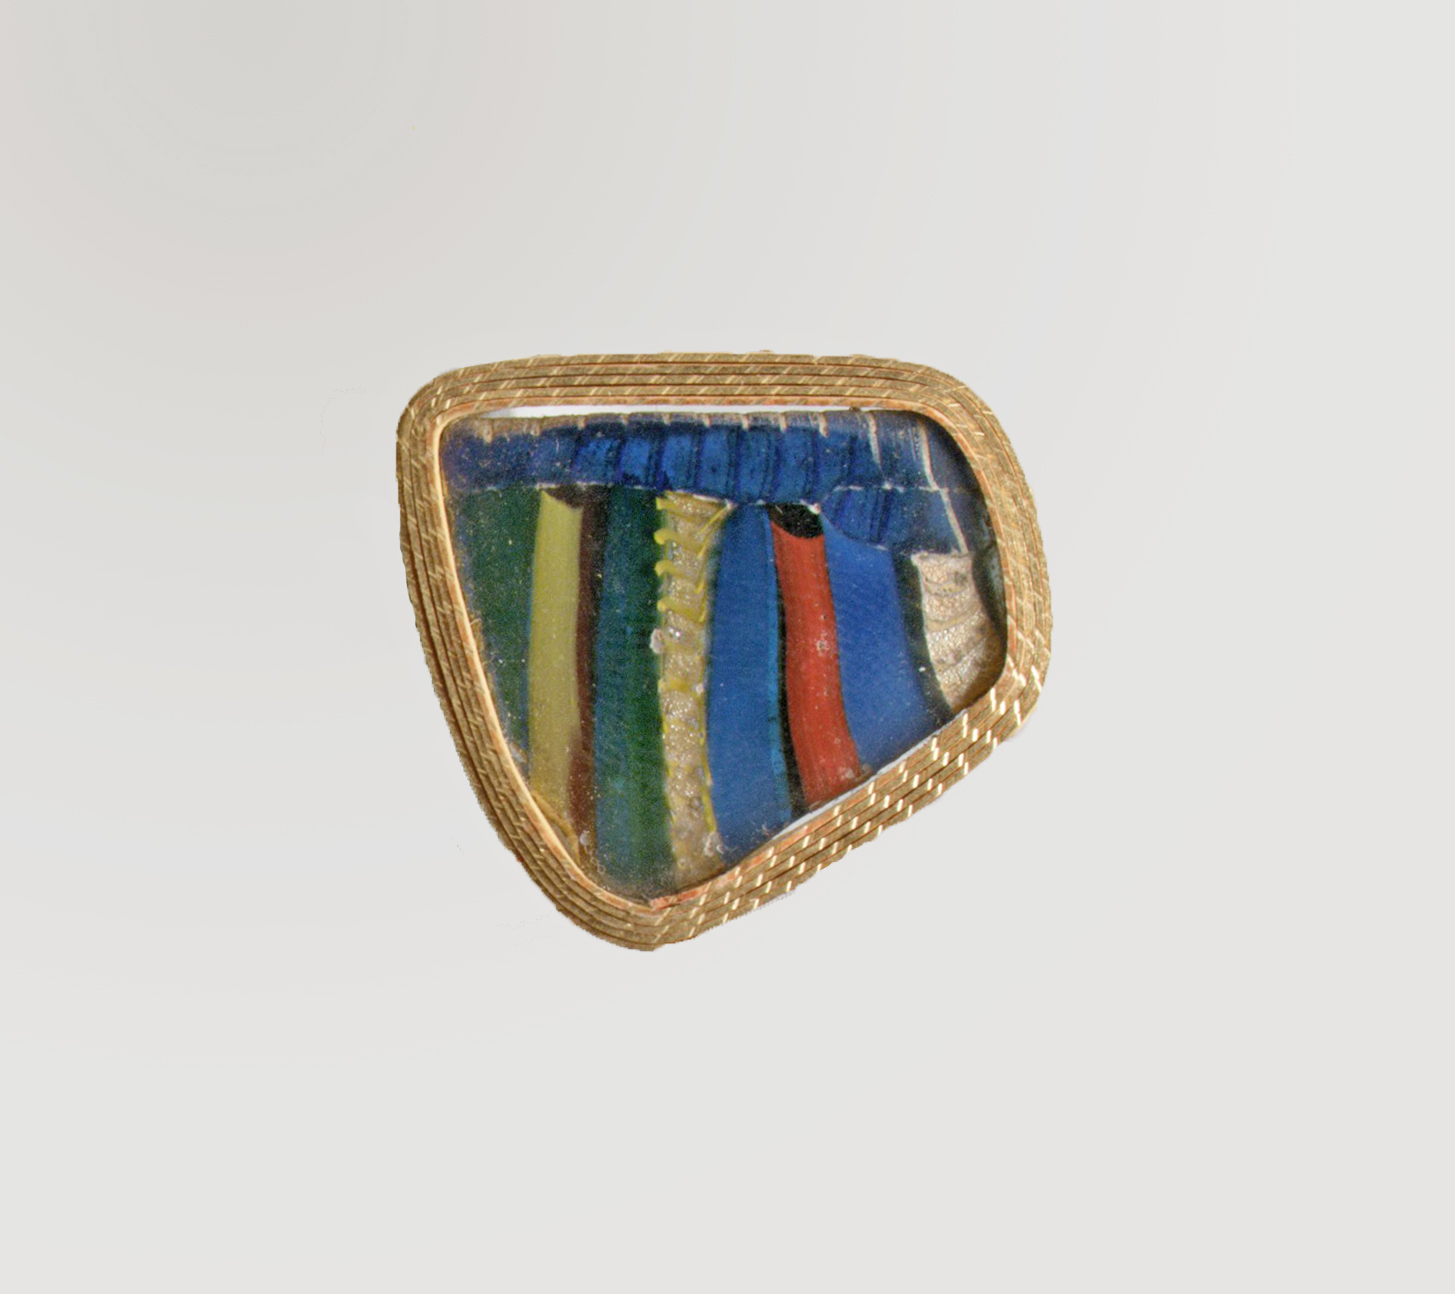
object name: fragment, mosaic bowl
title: Glass striped mosaic bowl fragment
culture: roman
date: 34 BCE-33 CE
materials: glass